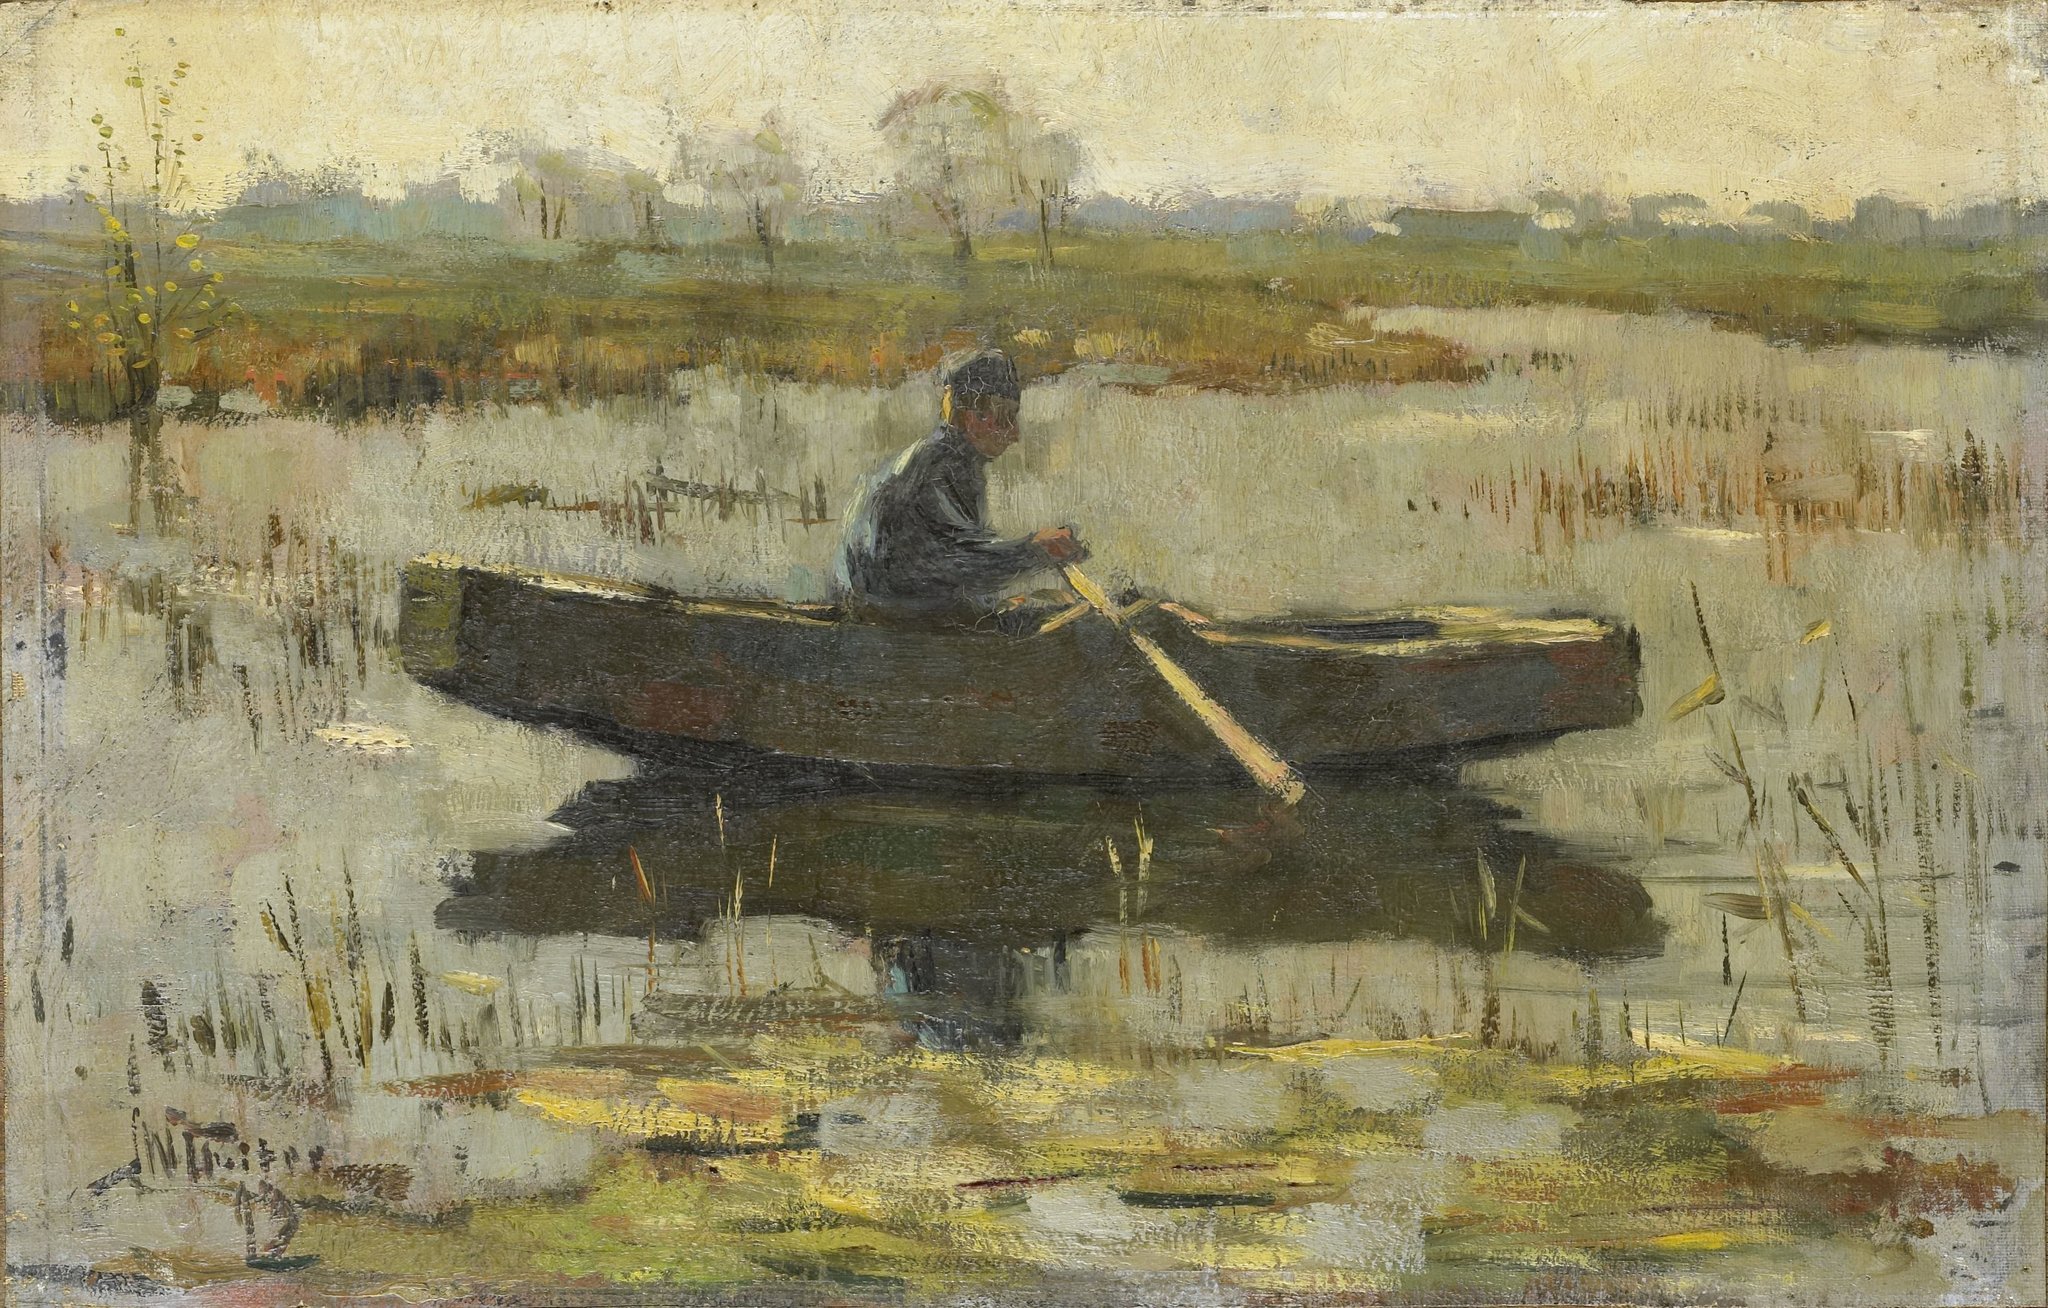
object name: painting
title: Man in een roeiboot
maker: herman wolbers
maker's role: painter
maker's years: 1856-1926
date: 1880-1926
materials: oil, panel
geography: netherlands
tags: meadow, pasture, rowing-boat, canoe, etc.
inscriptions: signature: ‘H. Wolbers’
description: Een man in een roeiboot in een plassengebied.